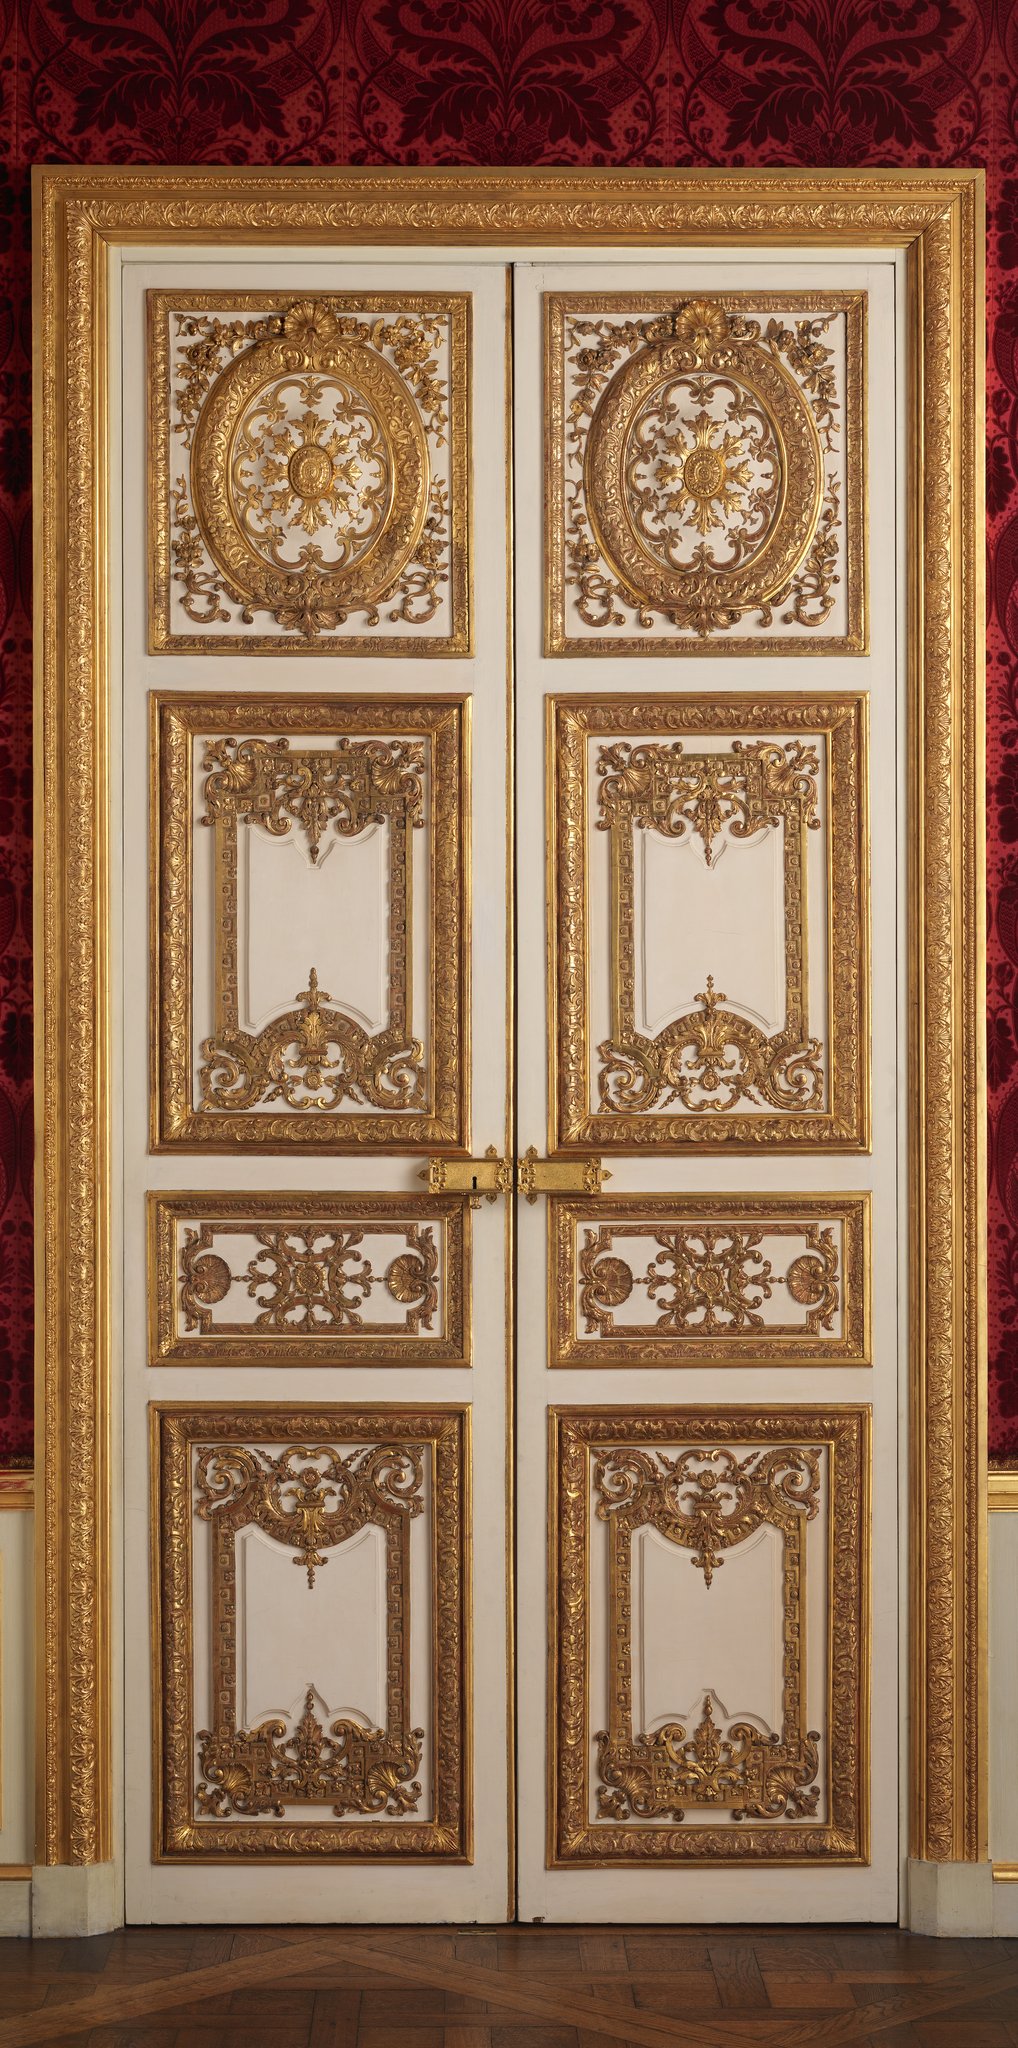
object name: double door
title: Pair of double doors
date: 1710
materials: gilt bronze, wood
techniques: carving, gilding, painting